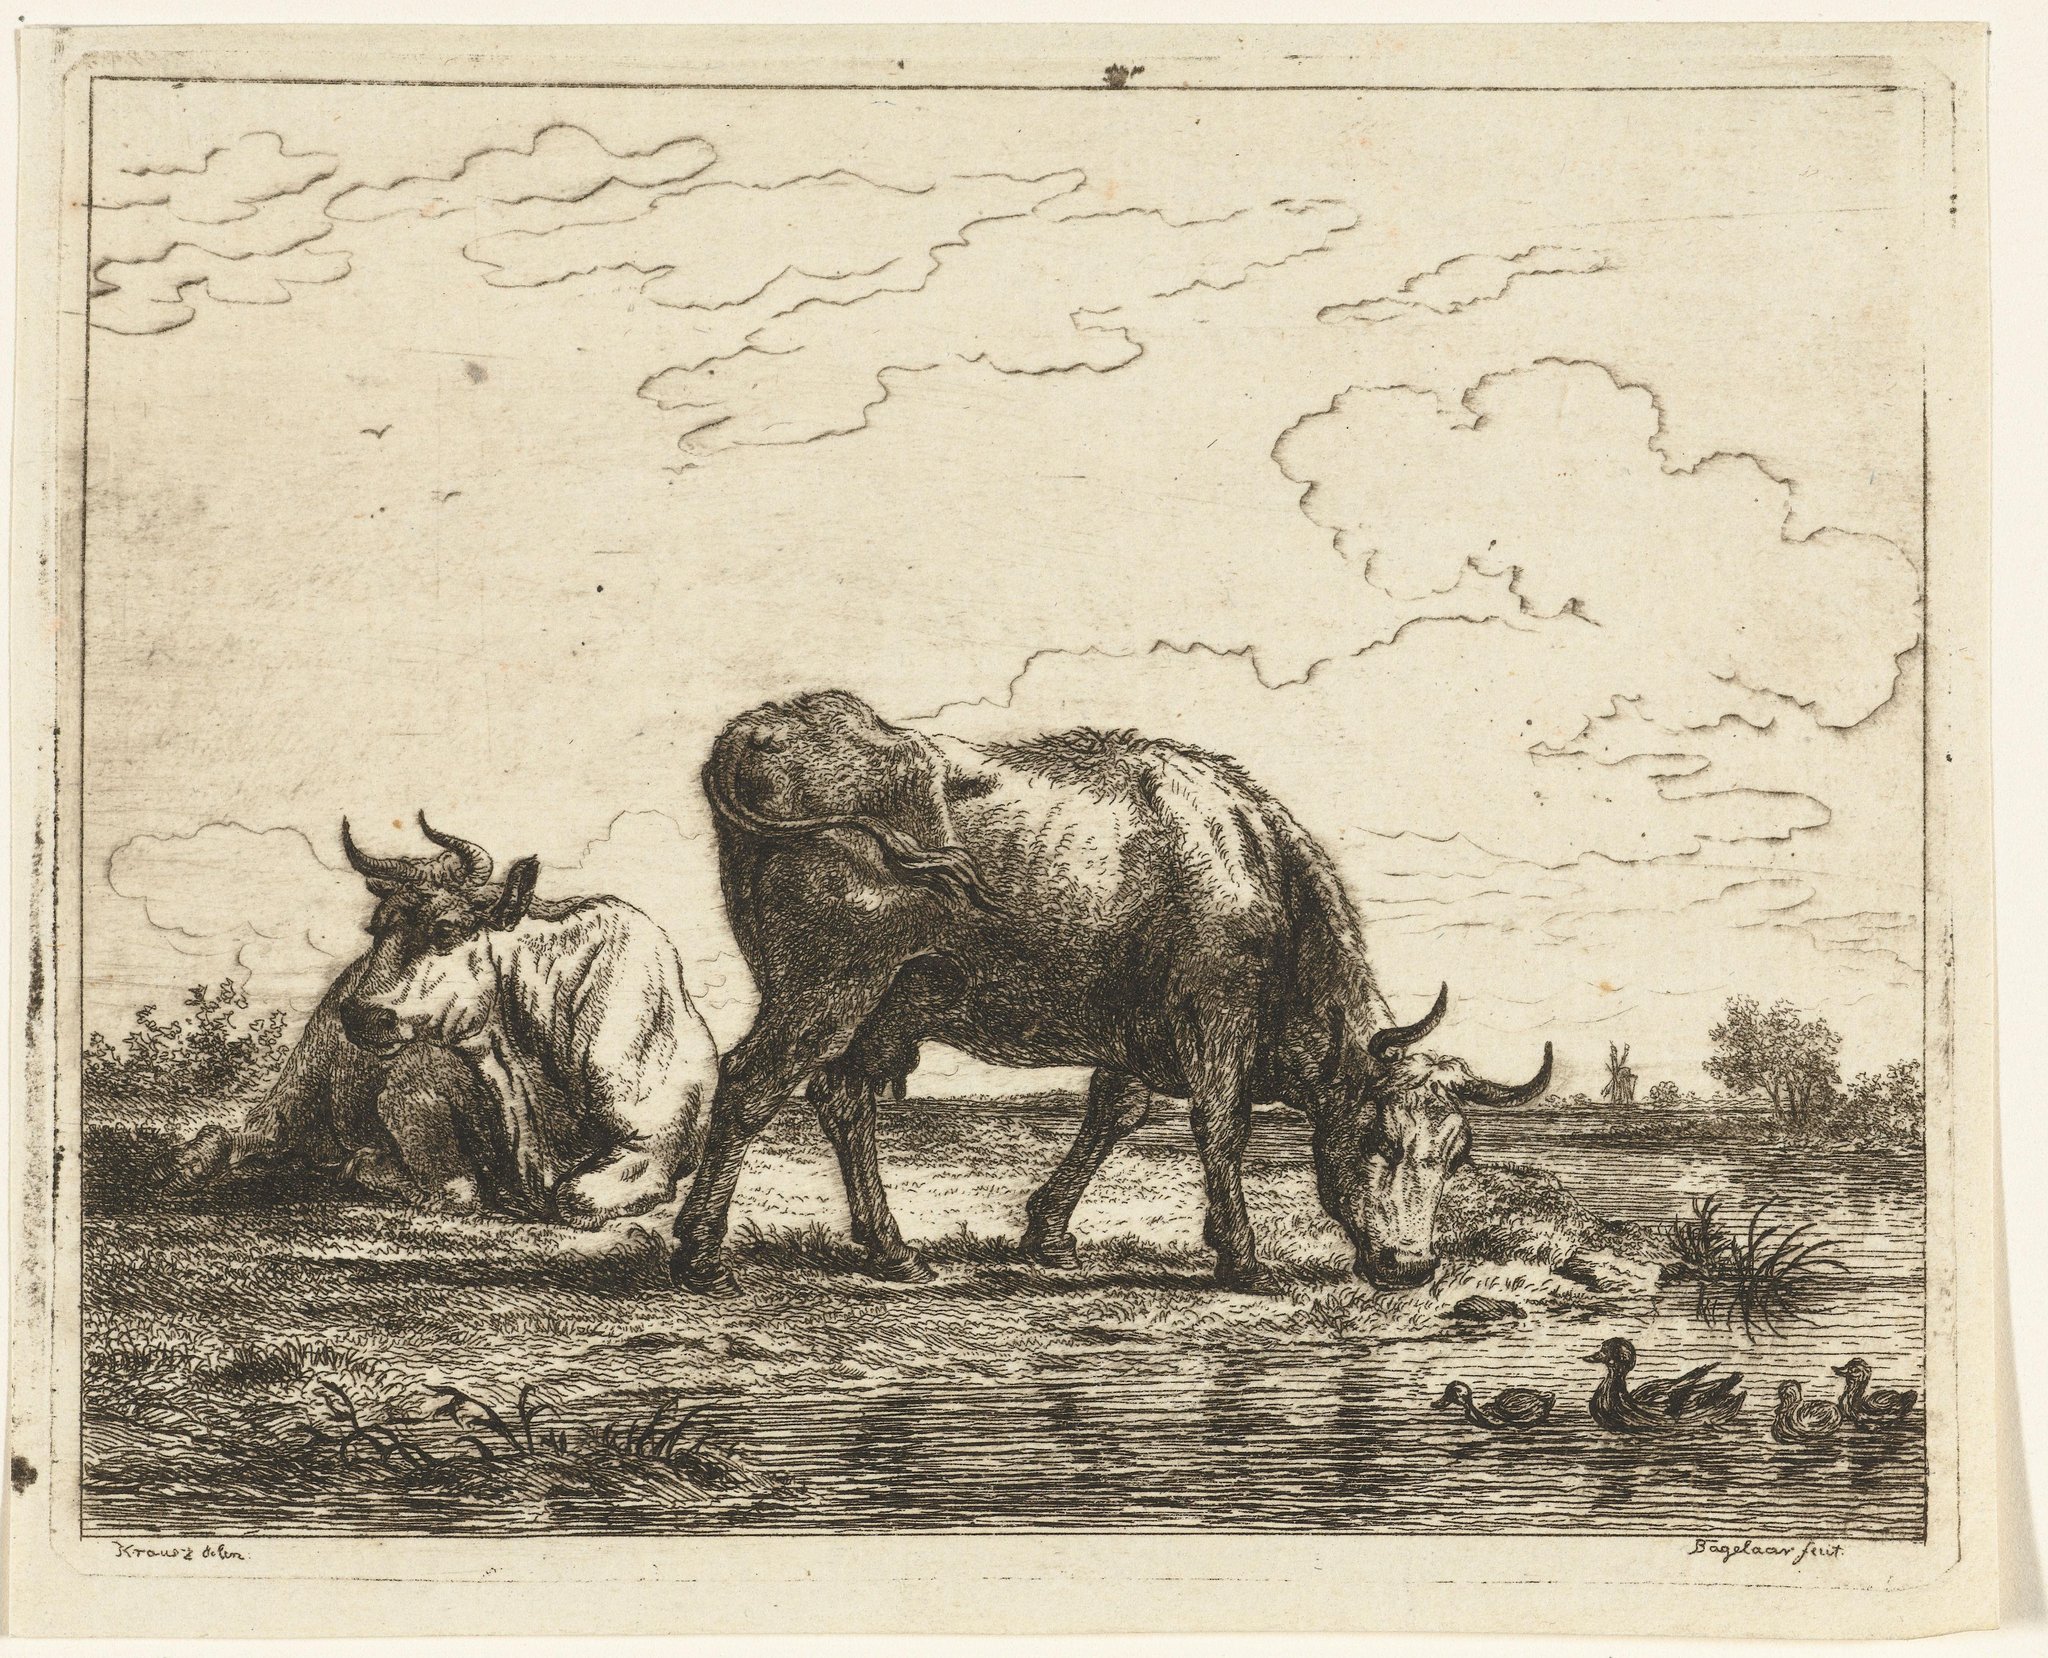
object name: print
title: Weiland met twee koeien bij een sloot met eenden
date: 1798-1837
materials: paper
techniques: etching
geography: netherlands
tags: landscapes in the temperate zone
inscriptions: collector's mark: Lugt 2228